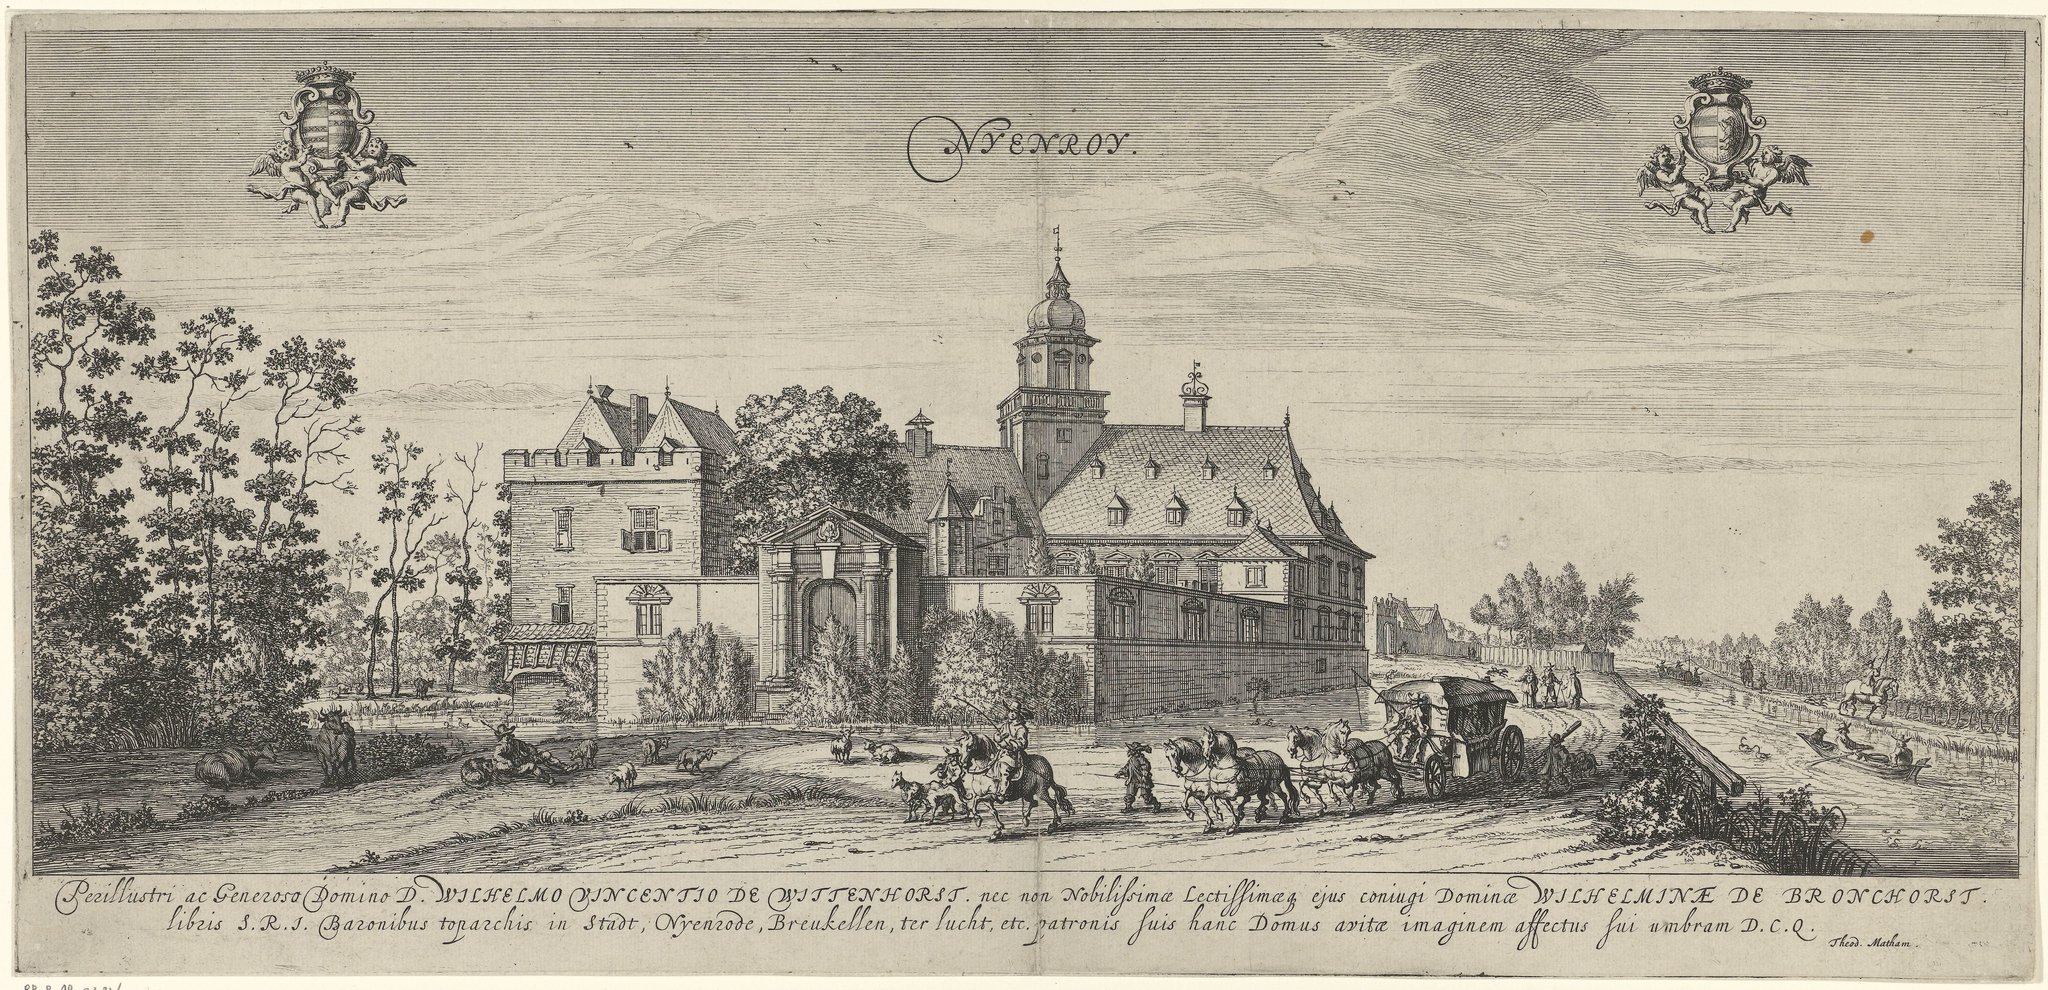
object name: print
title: Gezicht op Nijenrode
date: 1646-1676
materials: paper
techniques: engraving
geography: northern netherlands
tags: castle, rowing facing backward, pulling, four-wheeled vehicle drawn by more than three animals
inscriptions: collector's mark: Lugt 240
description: Gezicht op kasteel Nijenrode, waaromheen veel bedrijvigheid. Links- en rechtsboven twee familiewapens elk gedragen door twee putti.